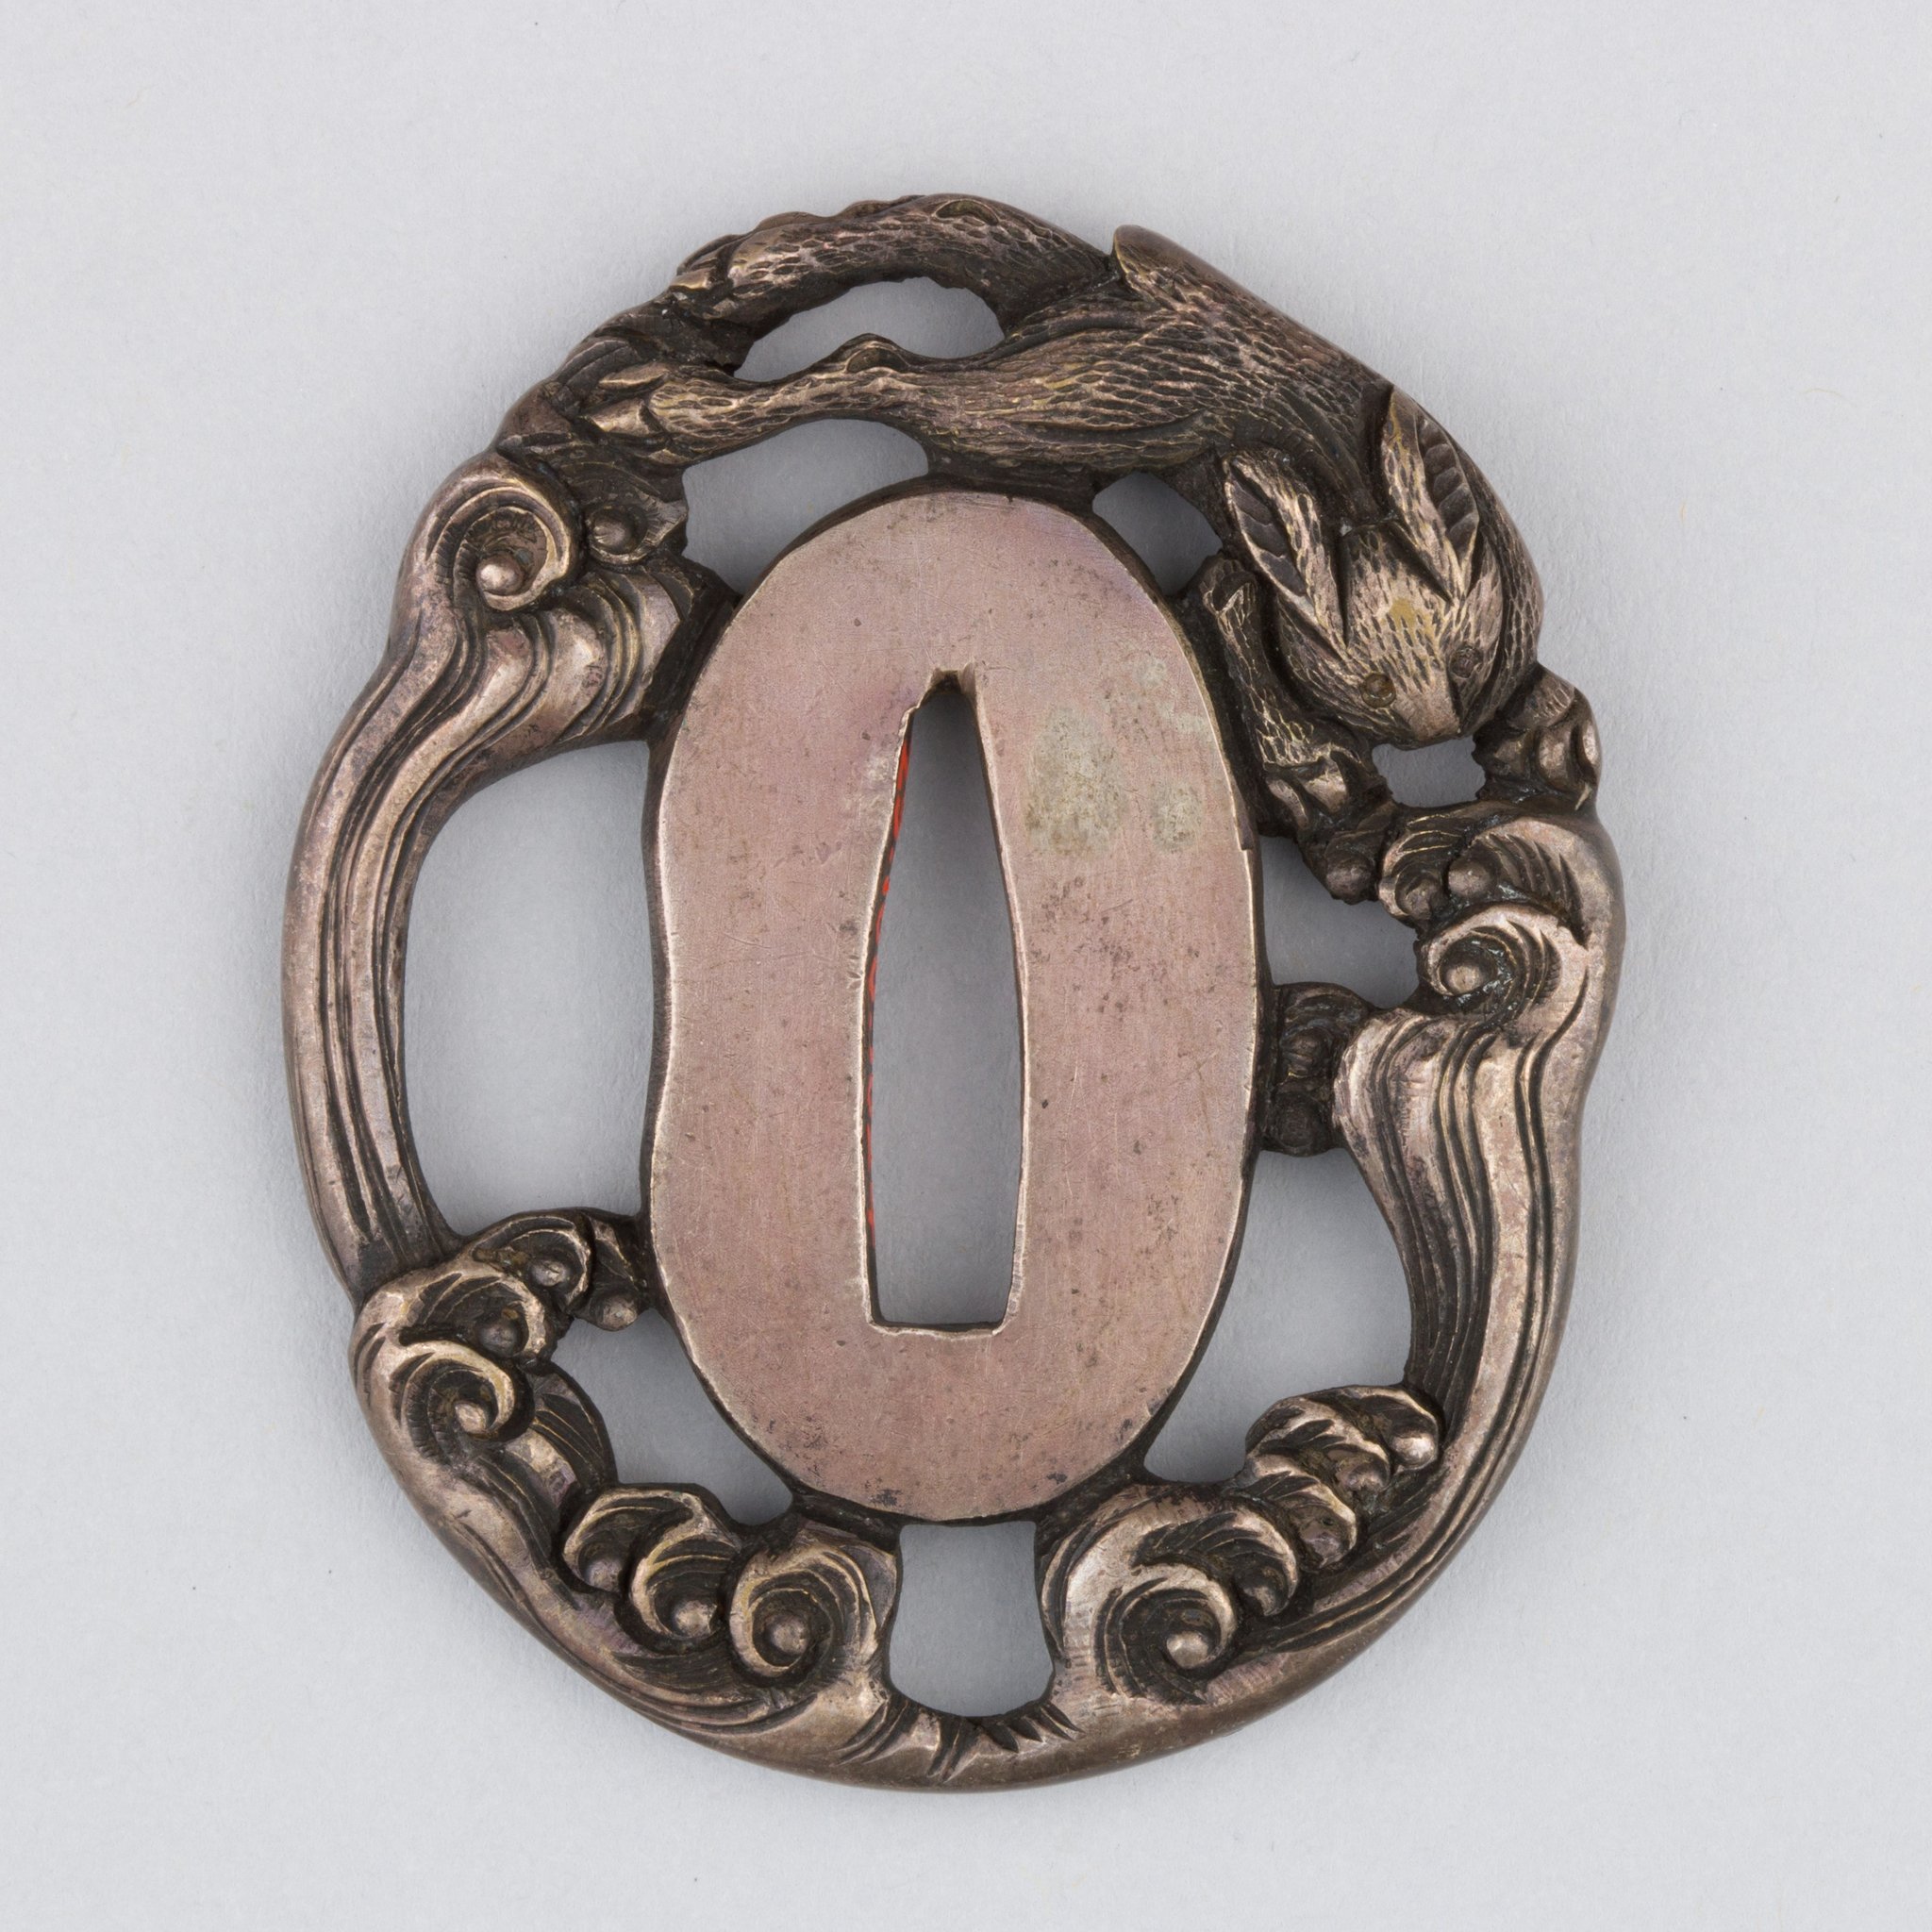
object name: sword guard tsuba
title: Sword Guard (Tsuba)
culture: japanese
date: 1615-1868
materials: copper, silver alloy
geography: japan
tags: rabbits